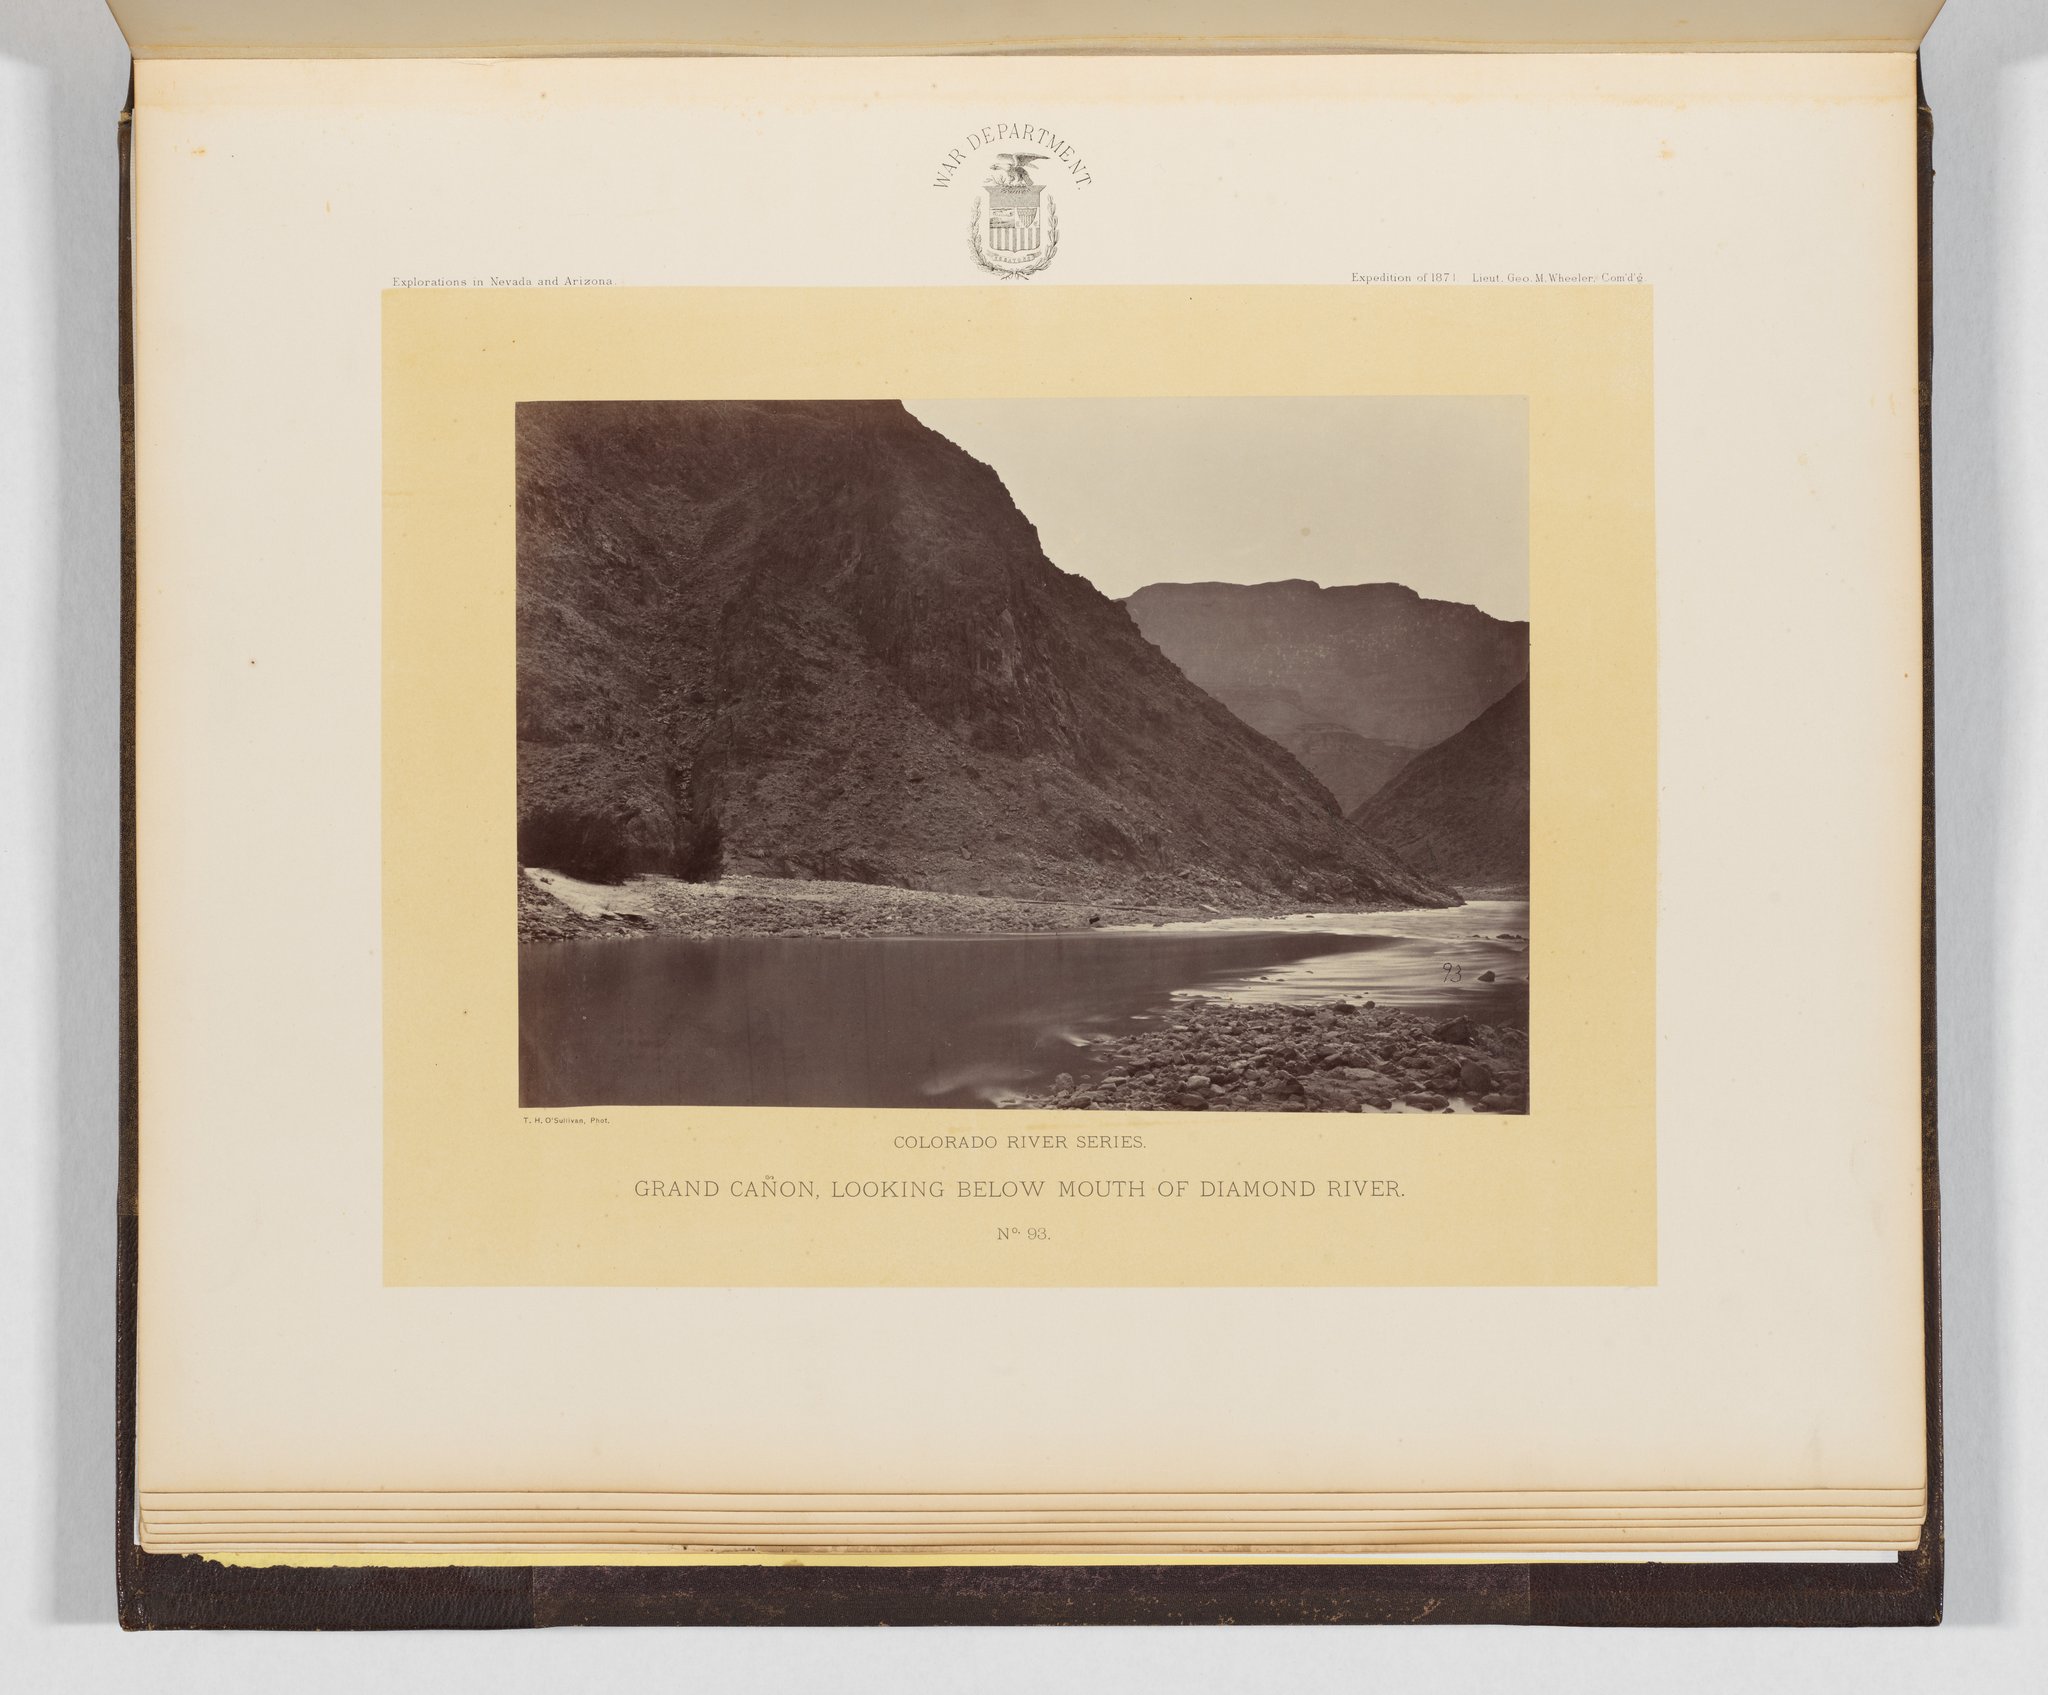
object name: photograph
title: Grand Cañon, Looking Below Mouth of Diamond River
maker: timothy h. o'sullivan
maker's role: artist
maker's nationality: american, born ireland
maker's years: 1840-1882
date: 1871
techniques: albumen silver print, glass negative